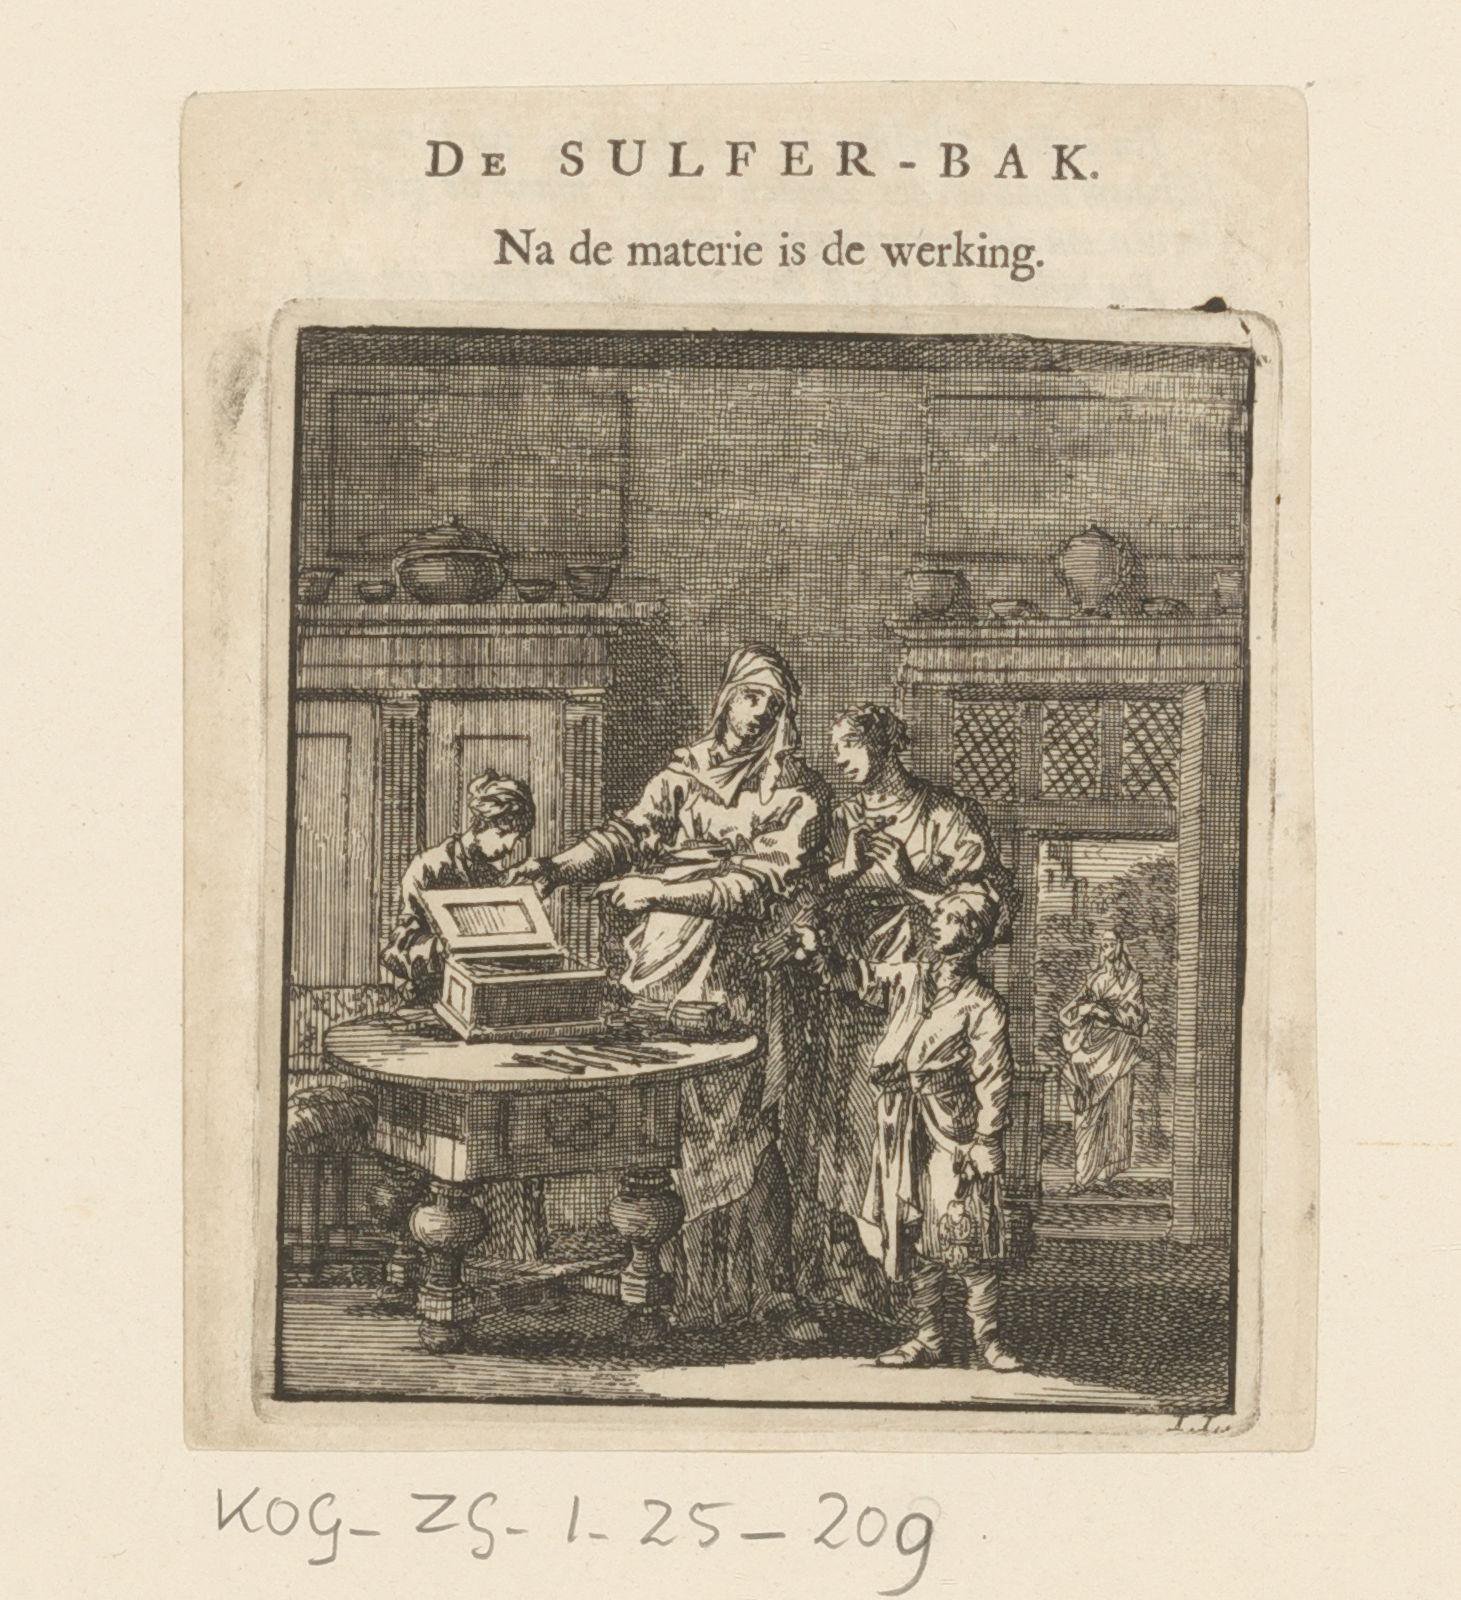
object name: book illustration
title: De Sulfer-bak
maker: jan luyken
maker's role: draughtsman, print maker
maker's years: 1649-1712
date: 1711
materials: paper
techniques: etching, letterpress printing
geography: amsterdam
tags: minerals and metals: sulphur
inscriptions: collector's mark: Lugt 1641, stamp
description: Prent uit: Luyken, Jan. Het leerzaam huisraad, vertoond in vyftig konstige figuuren, met godlyke spreuken en stichtelyke verzen. Amsterdam: weduwe Pieter Arentsz. II en Cornelis van der Sys, 1711, p. 96.